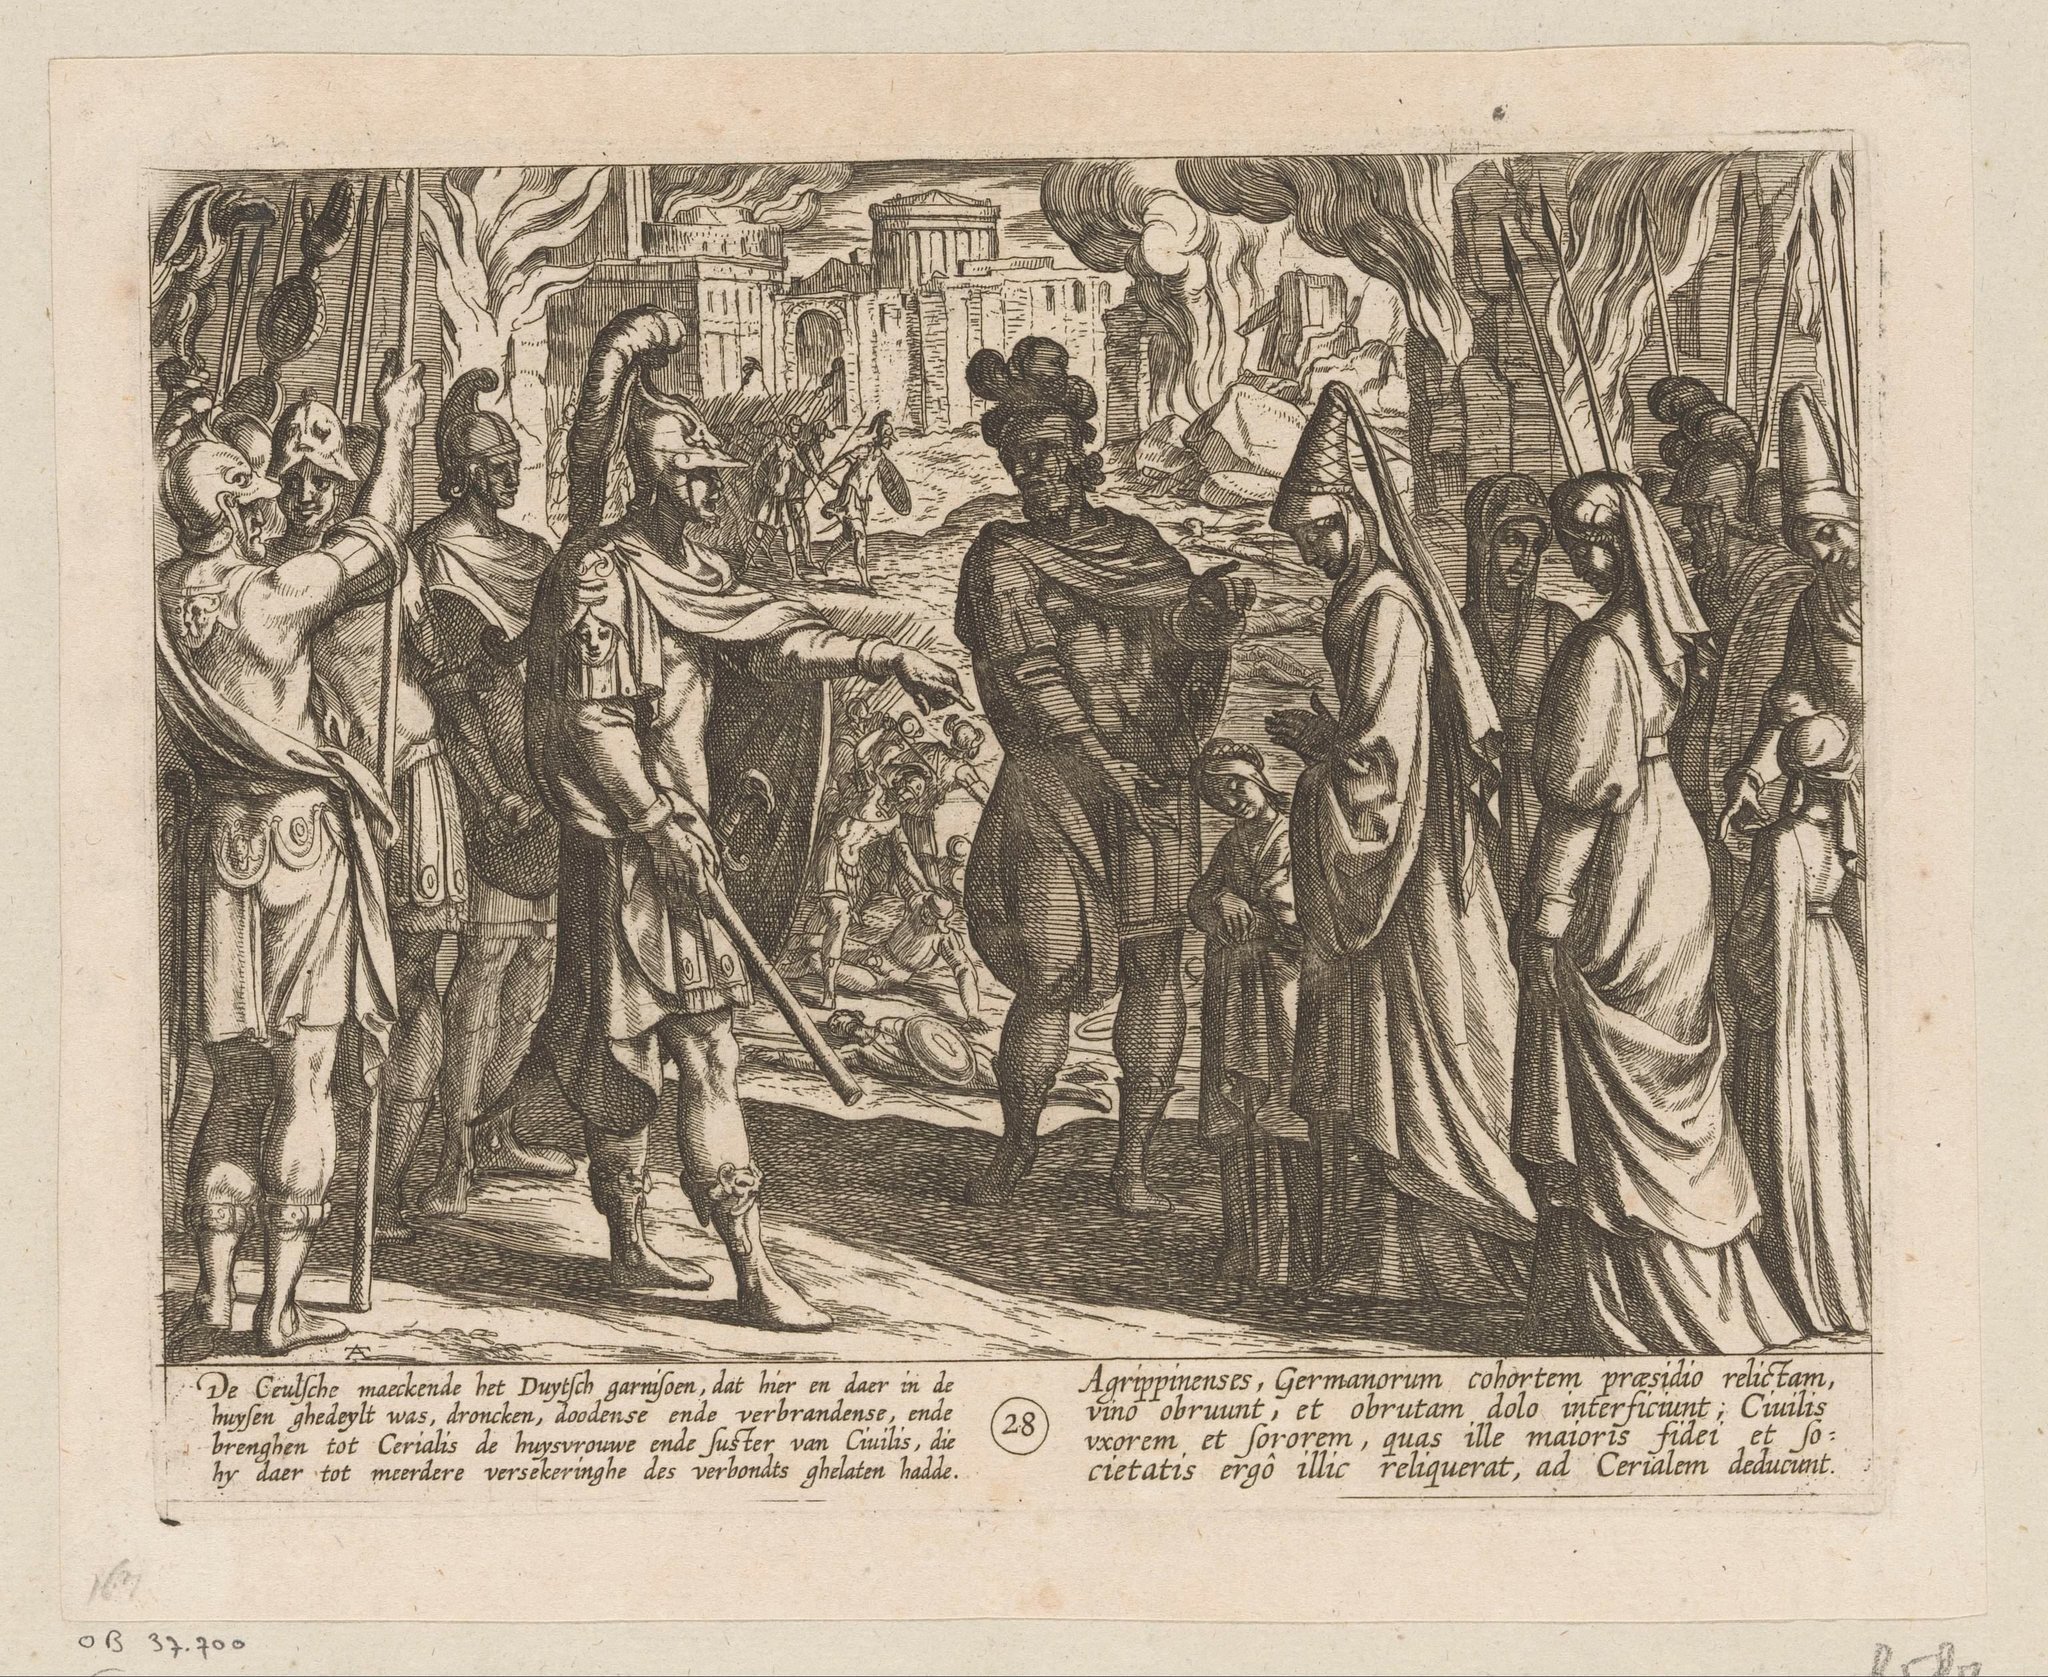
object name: print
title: Vrouw en zuster van Civilis voor Cerialis gebracht, 69-70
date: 1612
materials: paper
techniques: etching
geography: italy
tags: extinct, 'historical' peoples (with name), netherlands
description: De vrouw en zuster van Civilis worden voor Cerialis gebracht. Prent nummer 28 in de serie prenten over de Bataafse Opstand: Batavorum cum Romanis bellum / à Corn. Tacito lib. IV & V. : Hist. olim descriptum, figuris nunc aeneis expressum, auctore Othone Vaenio Lugdunobatava = De Batavische oft oude Hollandtsche oorloghe teghen de Romeynen. Otto Vaenius, Antwerpen 1612. Onderaan twee verzen van vier regels in het Nederlands en in het Latijn. Zonder tekst op achterzijde.